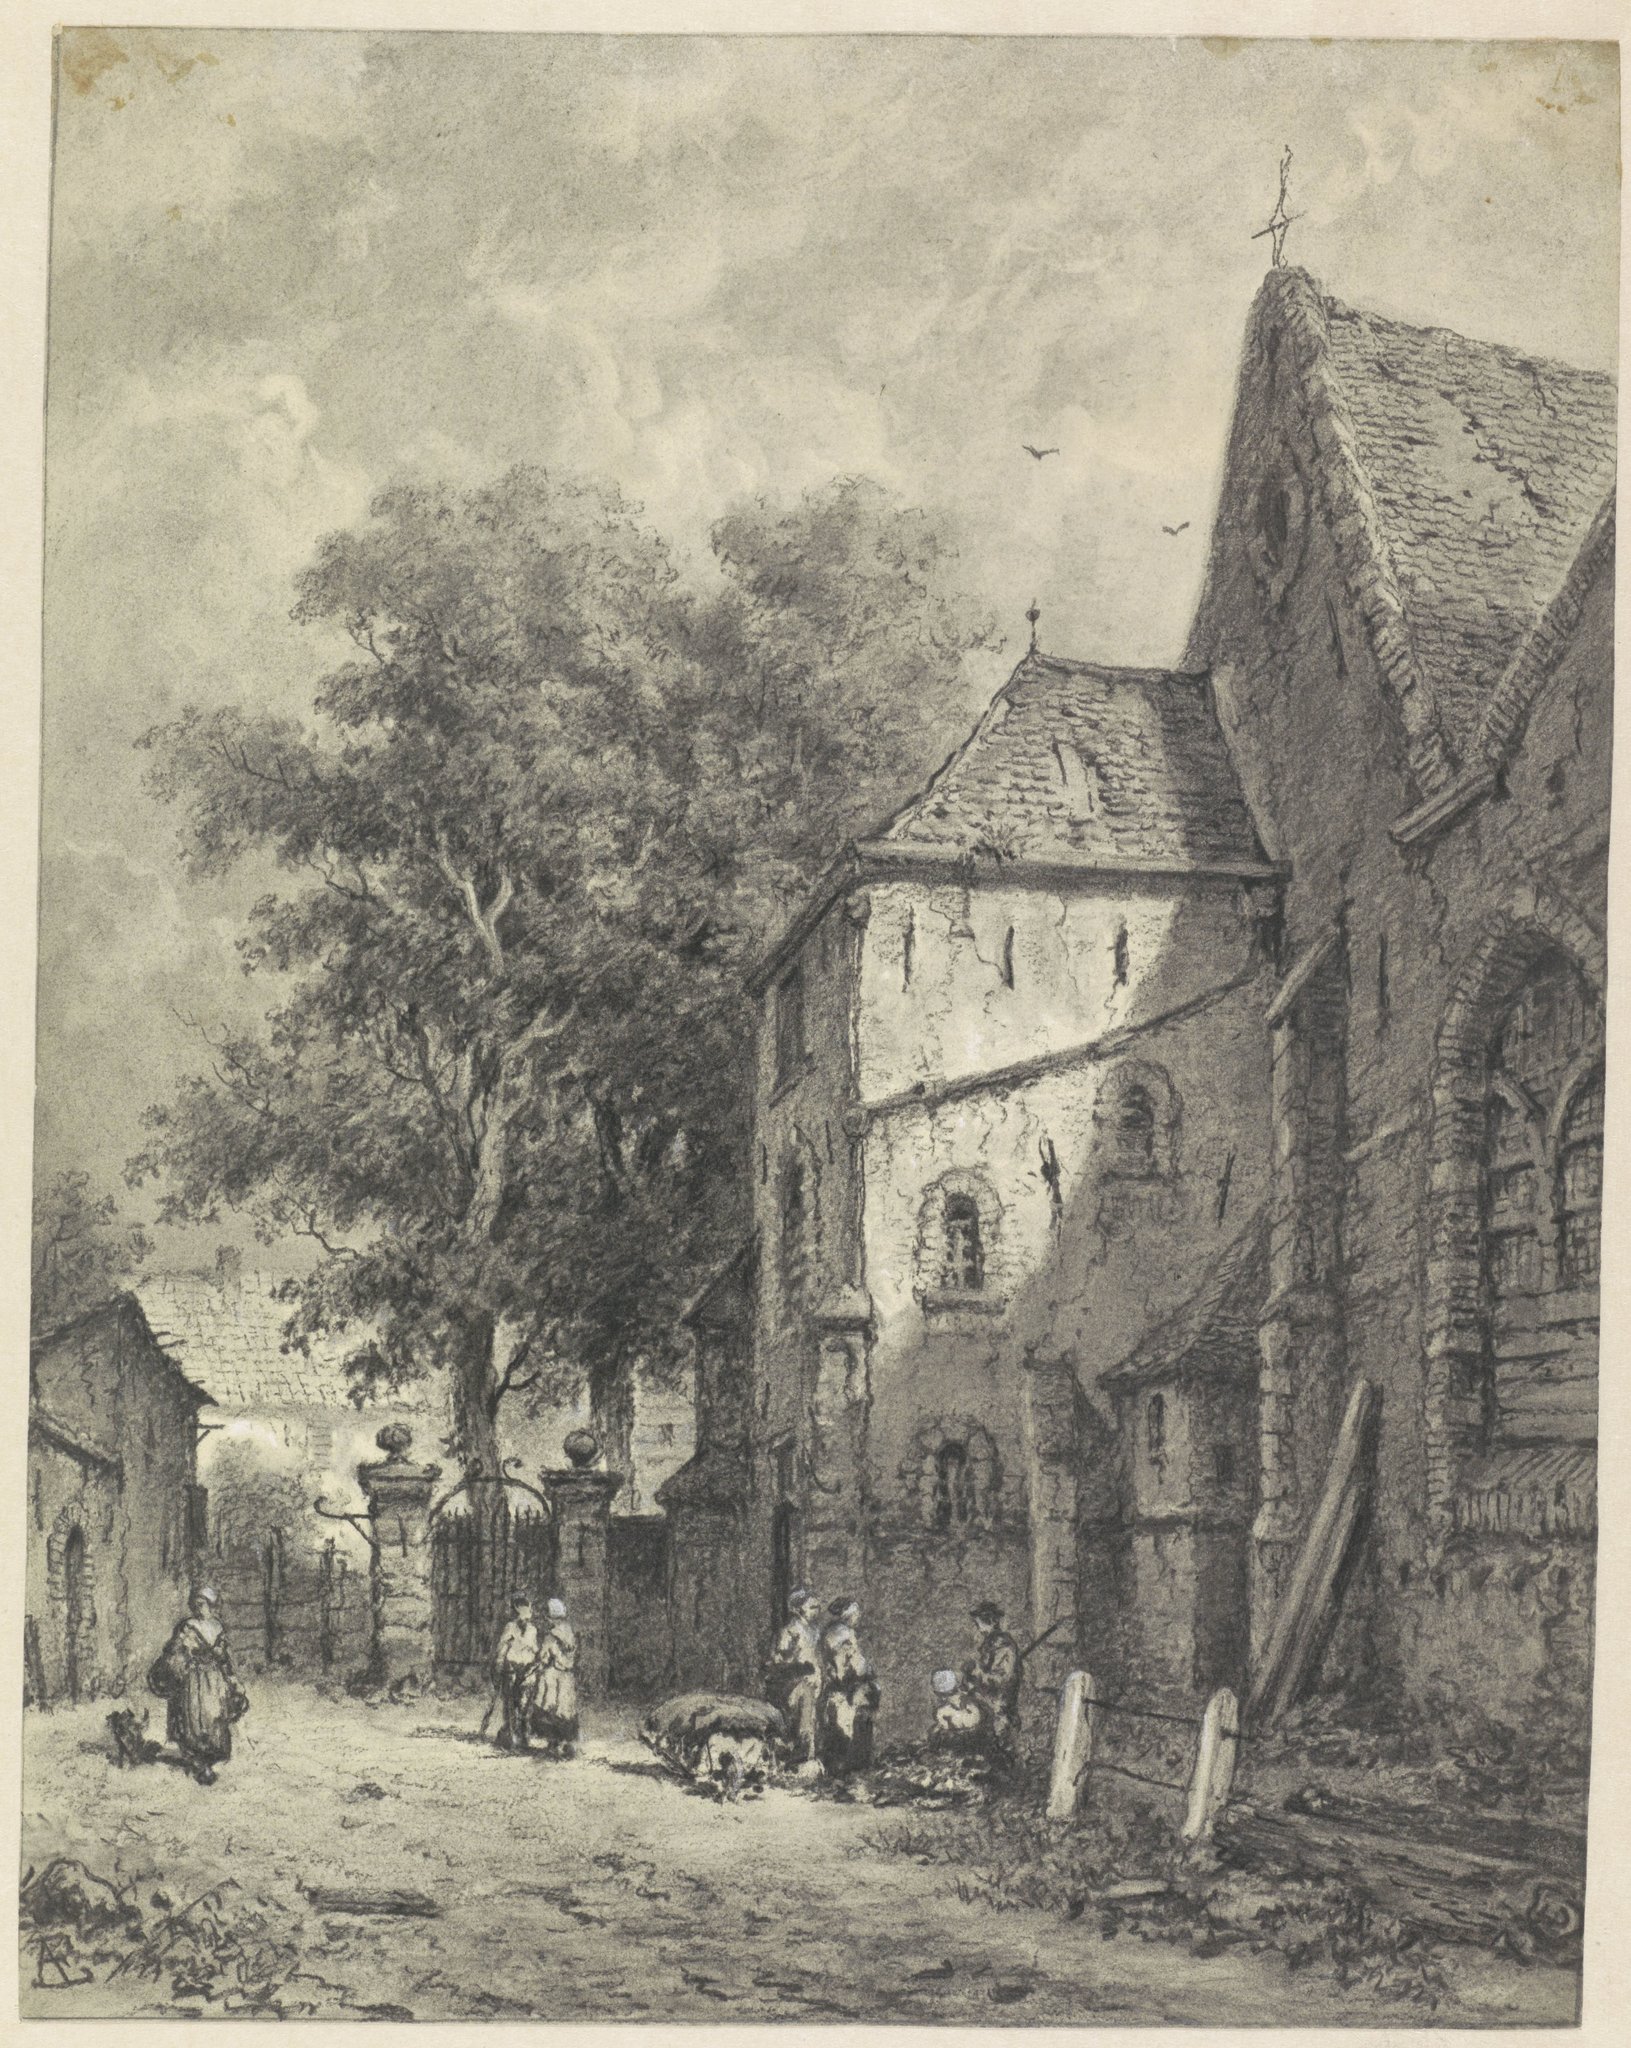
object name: drawing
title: Gezicht bij een kerk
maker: adrianus eversen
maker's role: draughtsman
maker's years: 1818-1897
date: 1874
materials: chalk, paper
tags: church (exterior)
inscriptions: date: ‘74’